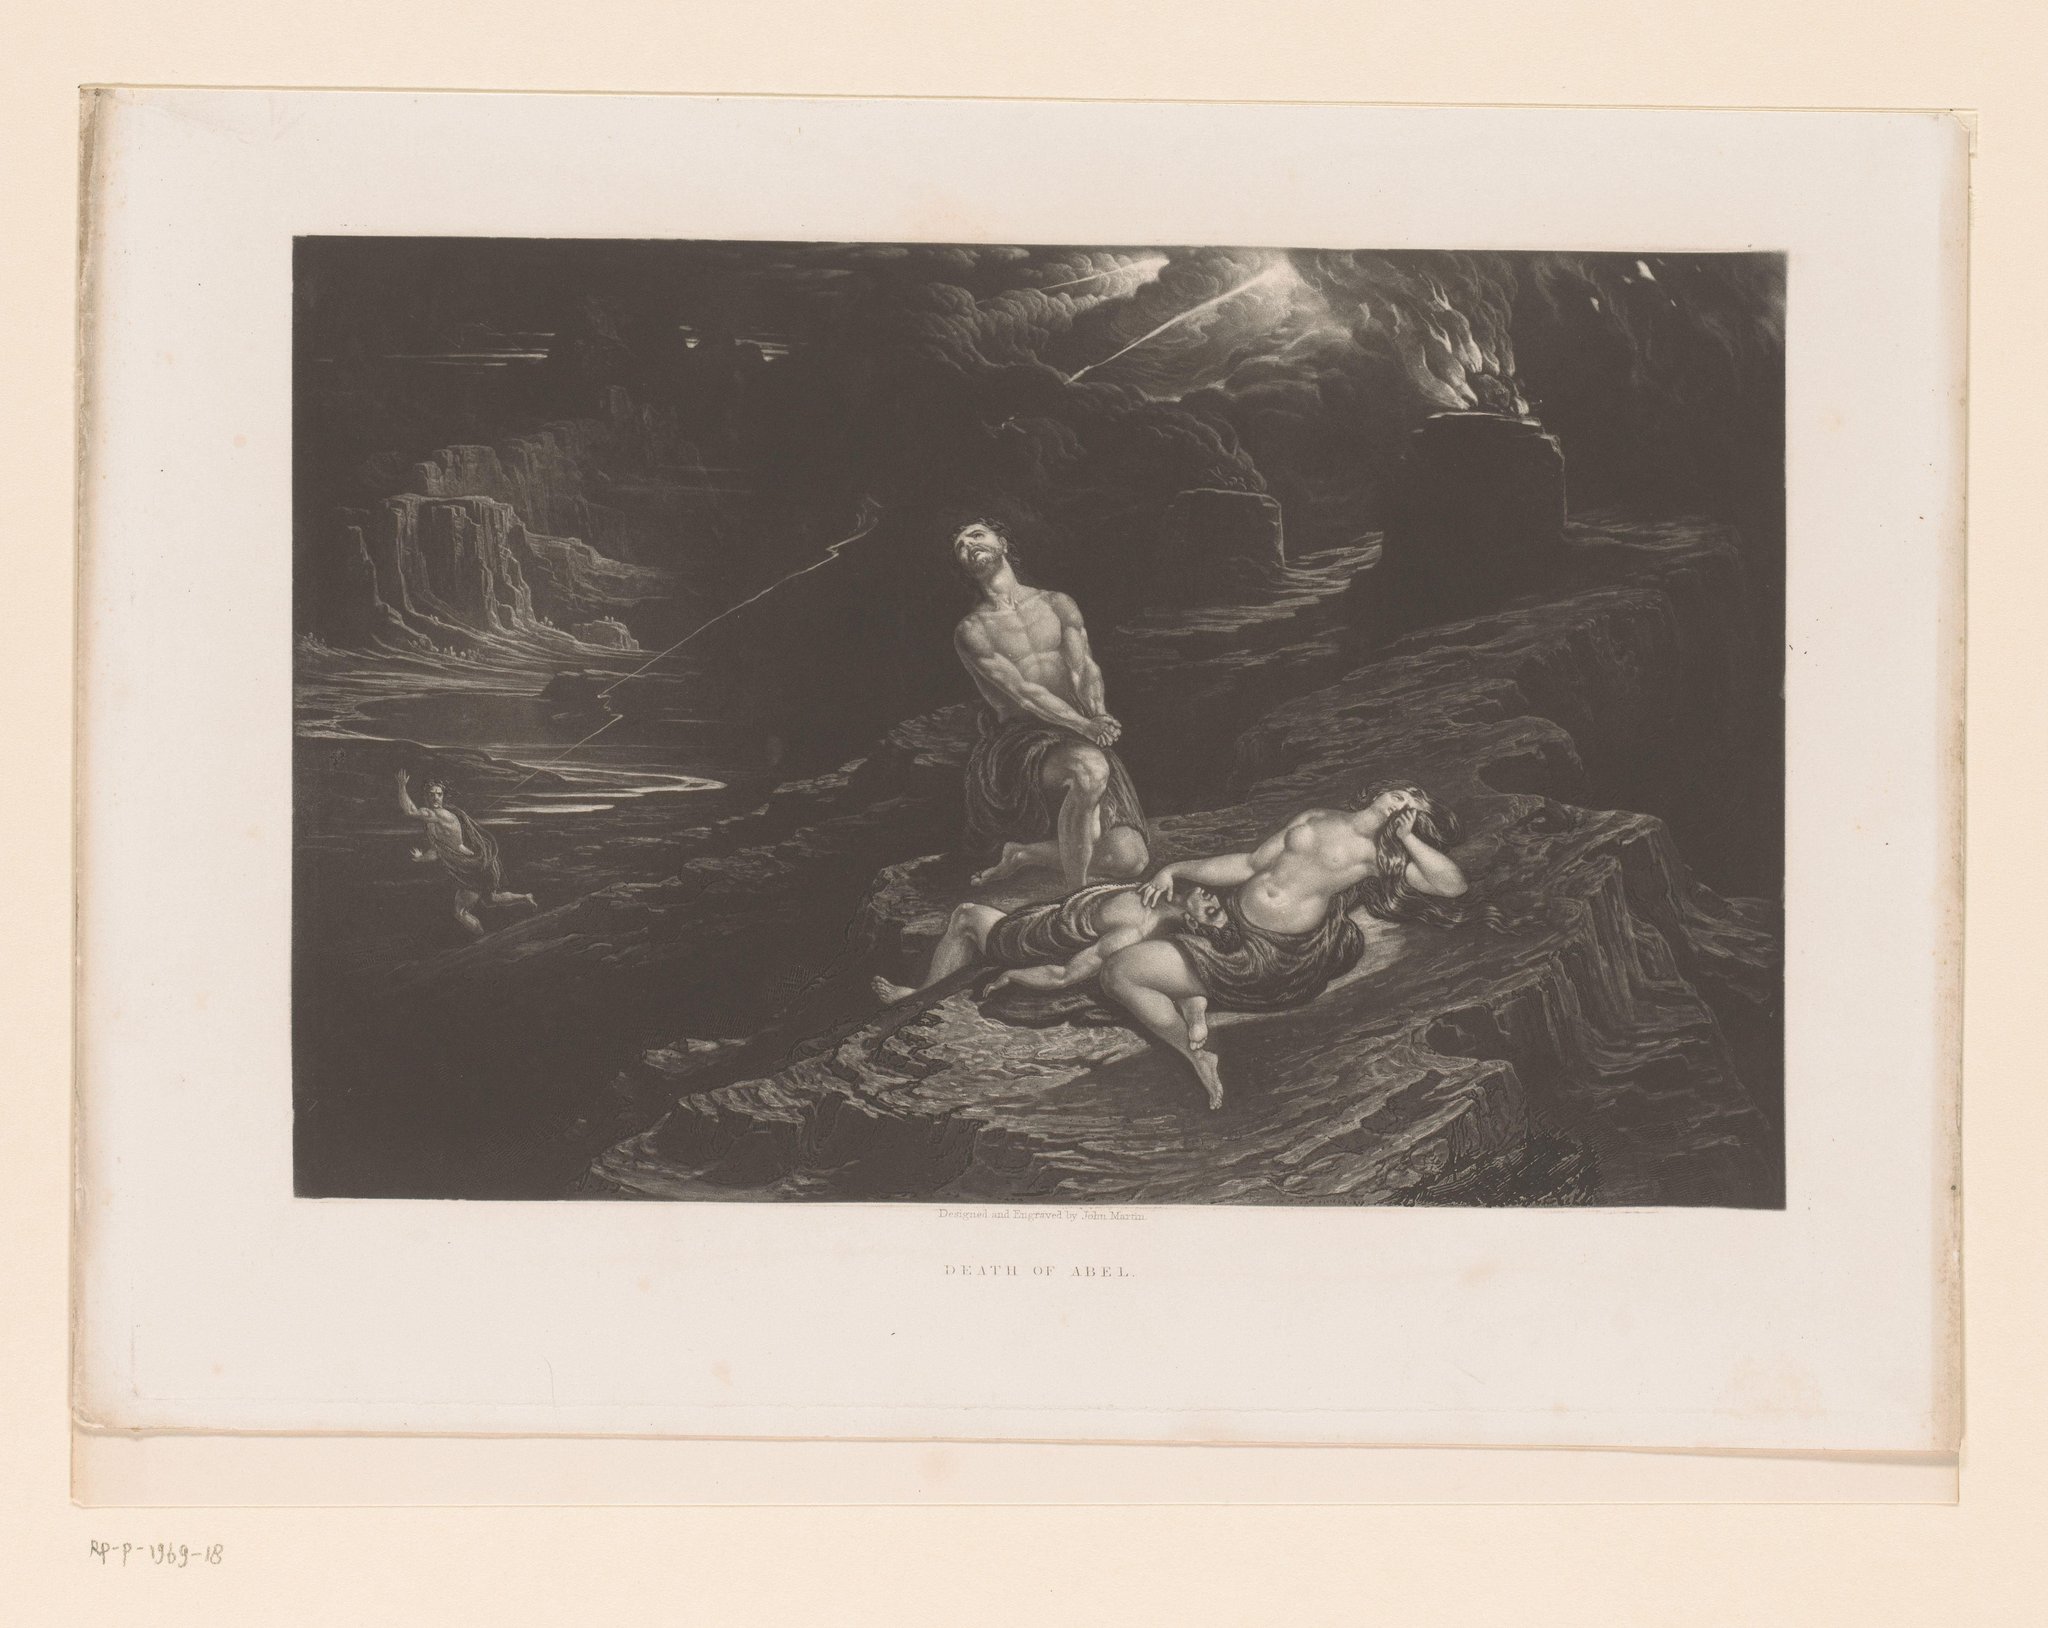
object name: print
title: Illustrations of the Bible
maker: john martin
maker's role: painter, print maker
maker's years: 1789-1854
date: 1831-1839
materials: paper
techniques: etching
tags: adam and eve discover the dead body of abel and grieve over it, the lord calls on cain to account for his deed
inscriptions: collector's mark: Lugt 2228, collector's mark: Lugt 2760